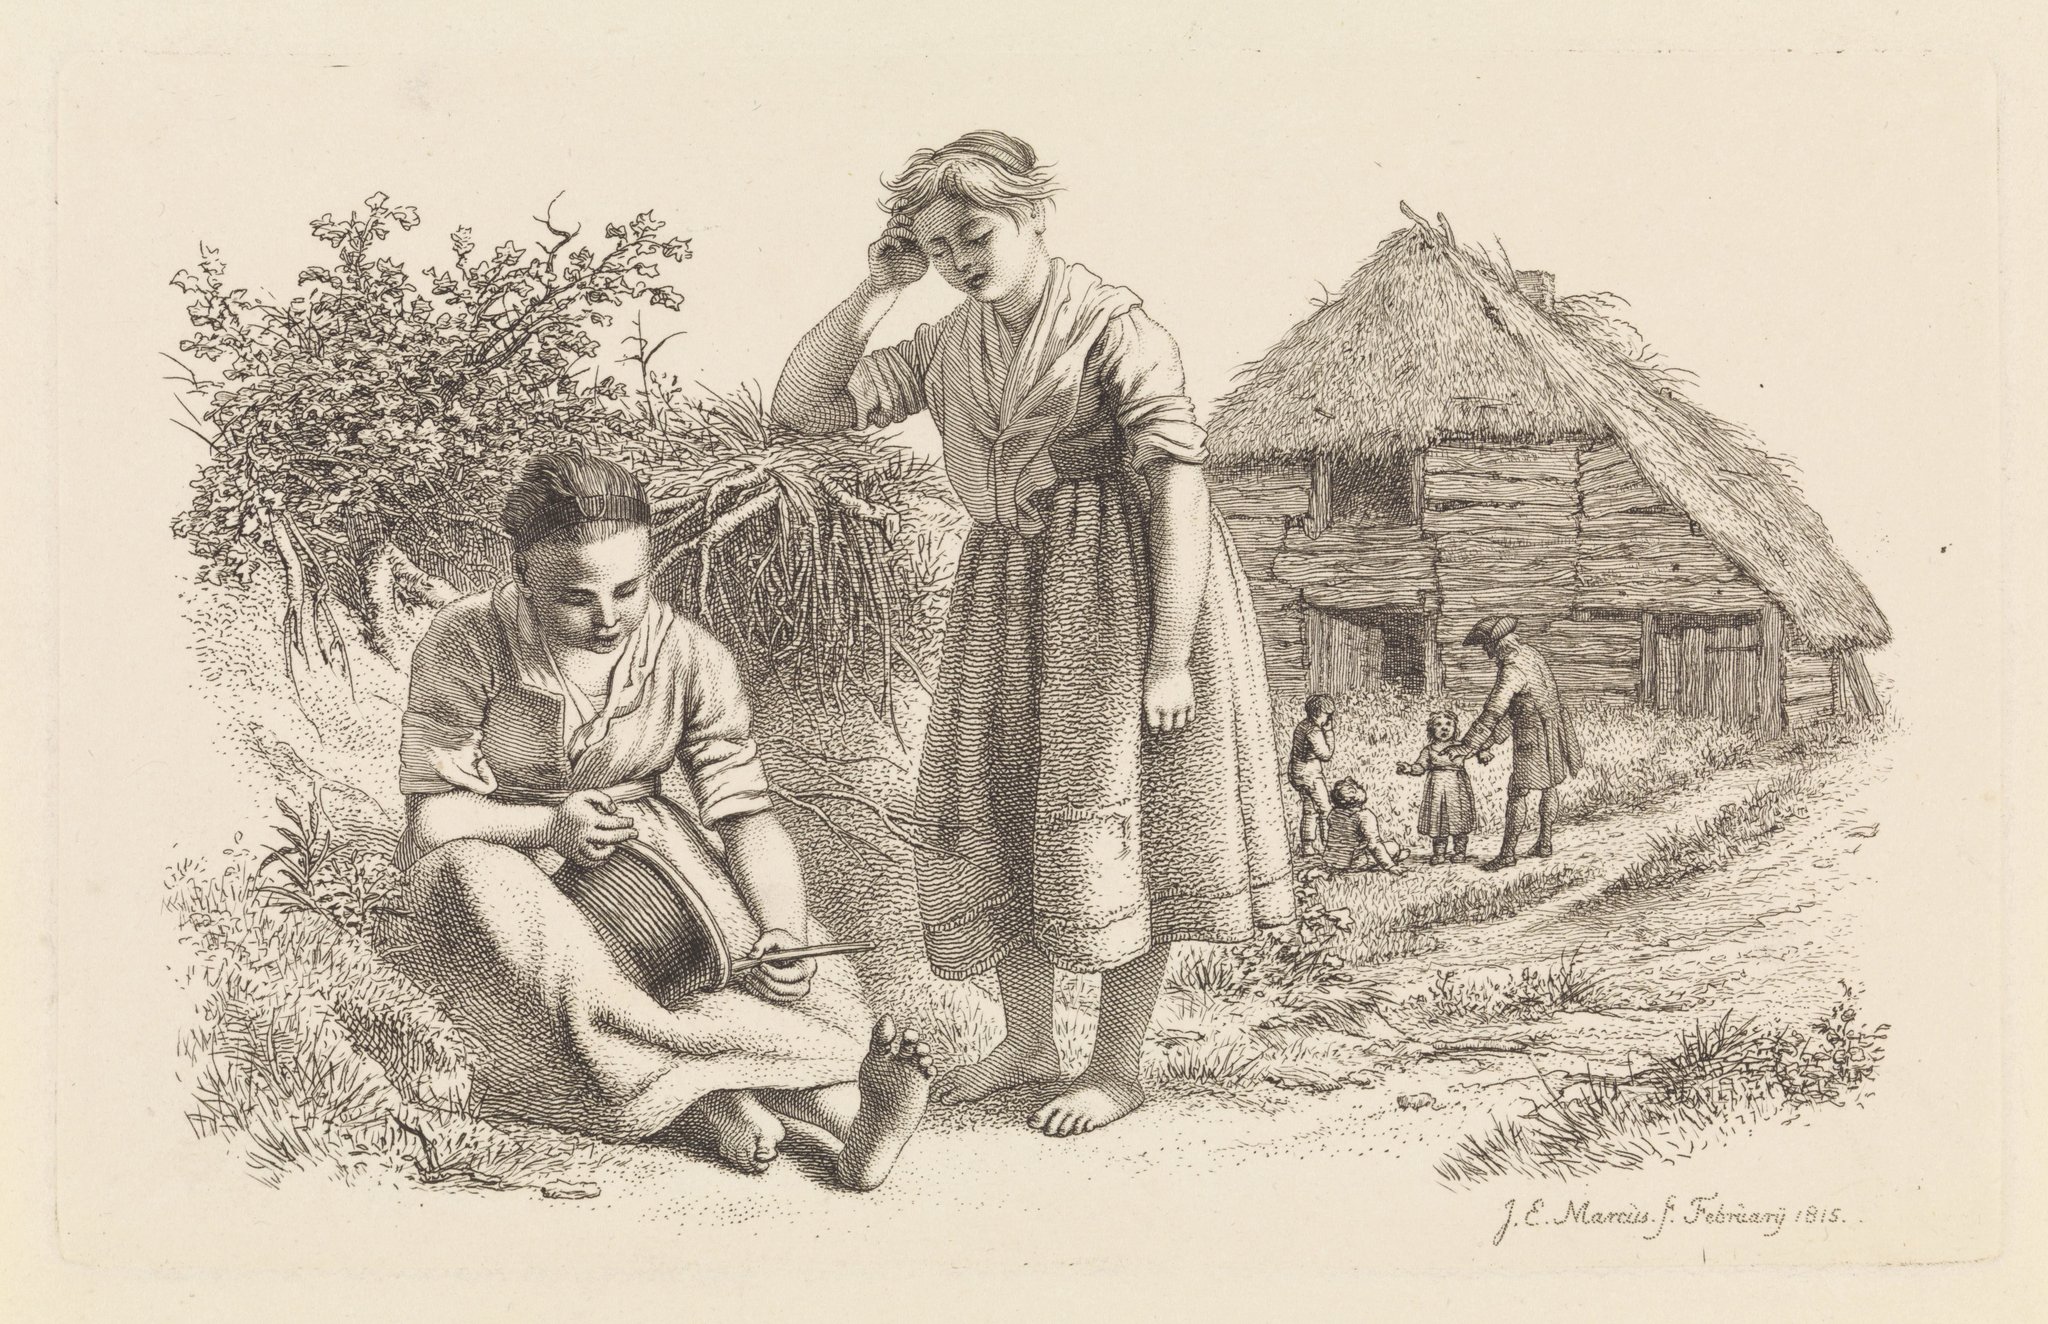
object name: print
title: Twee vrouwen en een man met kinderen voor een boerenschuur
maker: jacob ernst marcus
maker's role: draughtsman, print maker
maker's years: 1774-1826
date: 1802-1815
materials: paper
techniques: etching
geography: amsterdam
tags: barn, adolescent, young woman, maiden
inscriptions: collector's mark: Lugt 2228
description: Serie voor het eerst uitgegeven door Jacob Ernst Marcus onder de titel Studiebeelden en Fragmenten. Amsterdam: ca.1816. Later heruitgegeven als: Studie-prentwerk/ Etudes gravées.